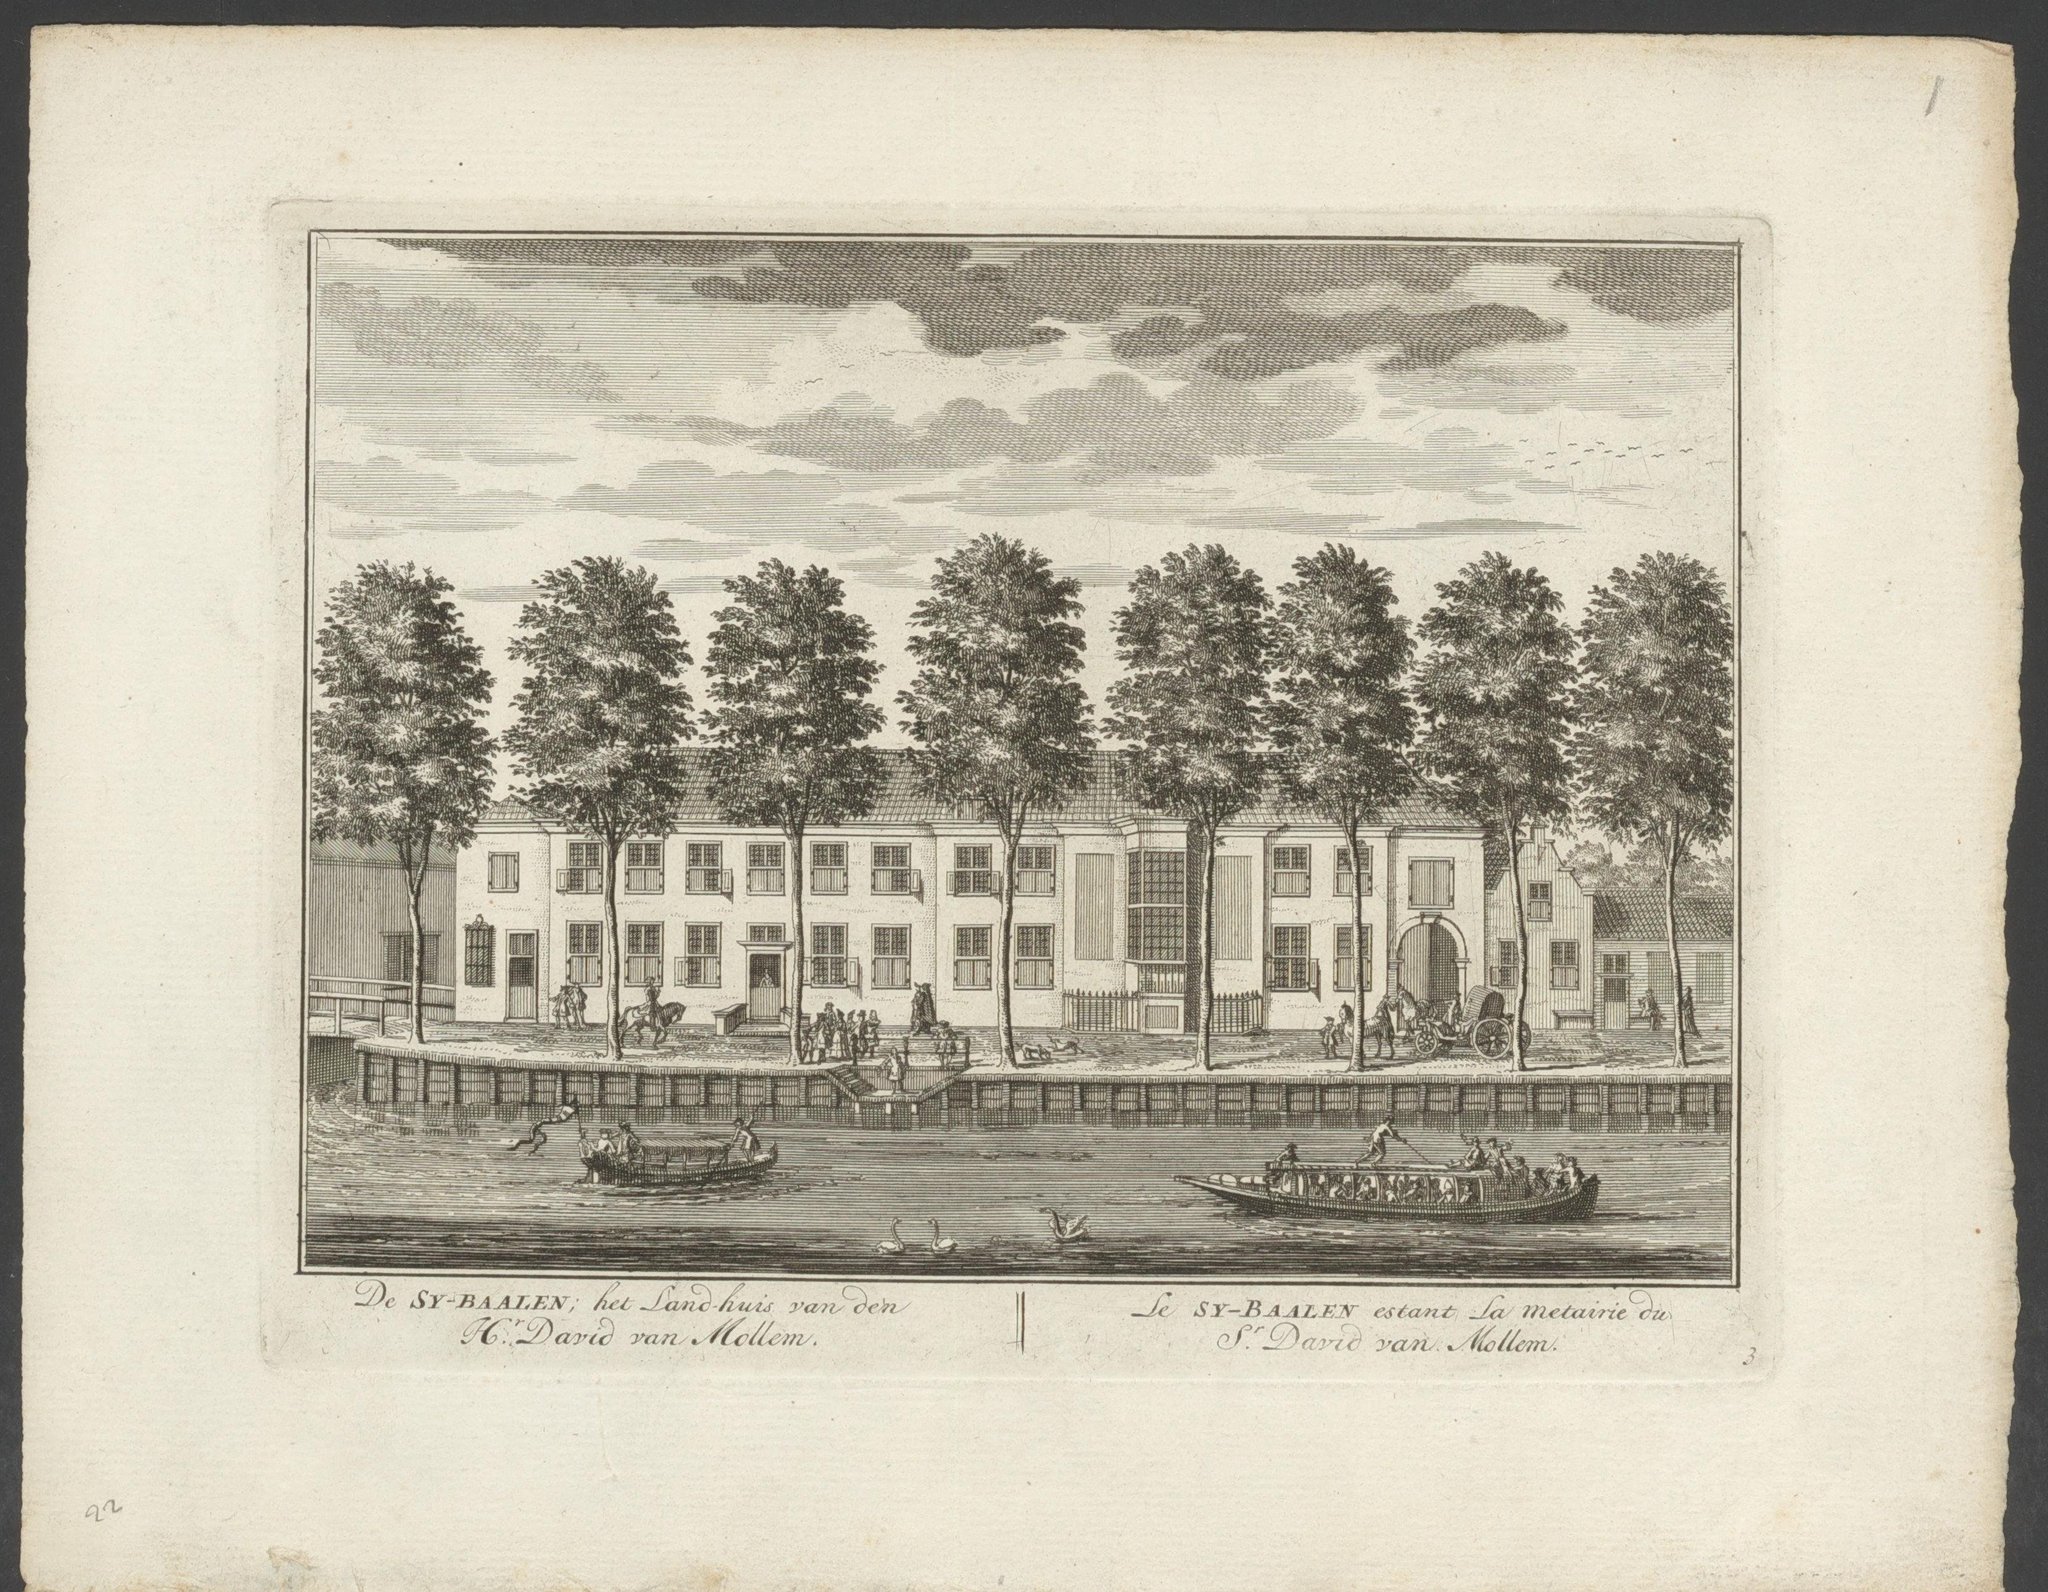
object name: print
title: De Sy-Baalen; het landhuis van der H. David van Mollem / Le Sy-Baalen estant la metairie du S. David van Mollem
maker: daniël stopendaal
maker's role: print maker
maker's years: 1672-1726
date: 1790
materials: paper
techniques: engraving, etching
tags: river, textile industry and clothing industry, vecht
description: Prent mogelijk uit: Leth, Andries de. De zegepraalende Vecht, vertoonende verscheidene gesichten van lustplaatsen, heeren huysen en dorpen, beginnende van Uitrecht en met Muyden besluytende (...). Amsterdam: Weduwe Nicolaus Visscher, 1719. Of uit: Brouërius van Nidek, Matthaeus. De Vechtstroom, van Utrecht tot Muiden (...). Amsterdam: H. Gartman, W. Vermandel en J.W. Smit, 1790.